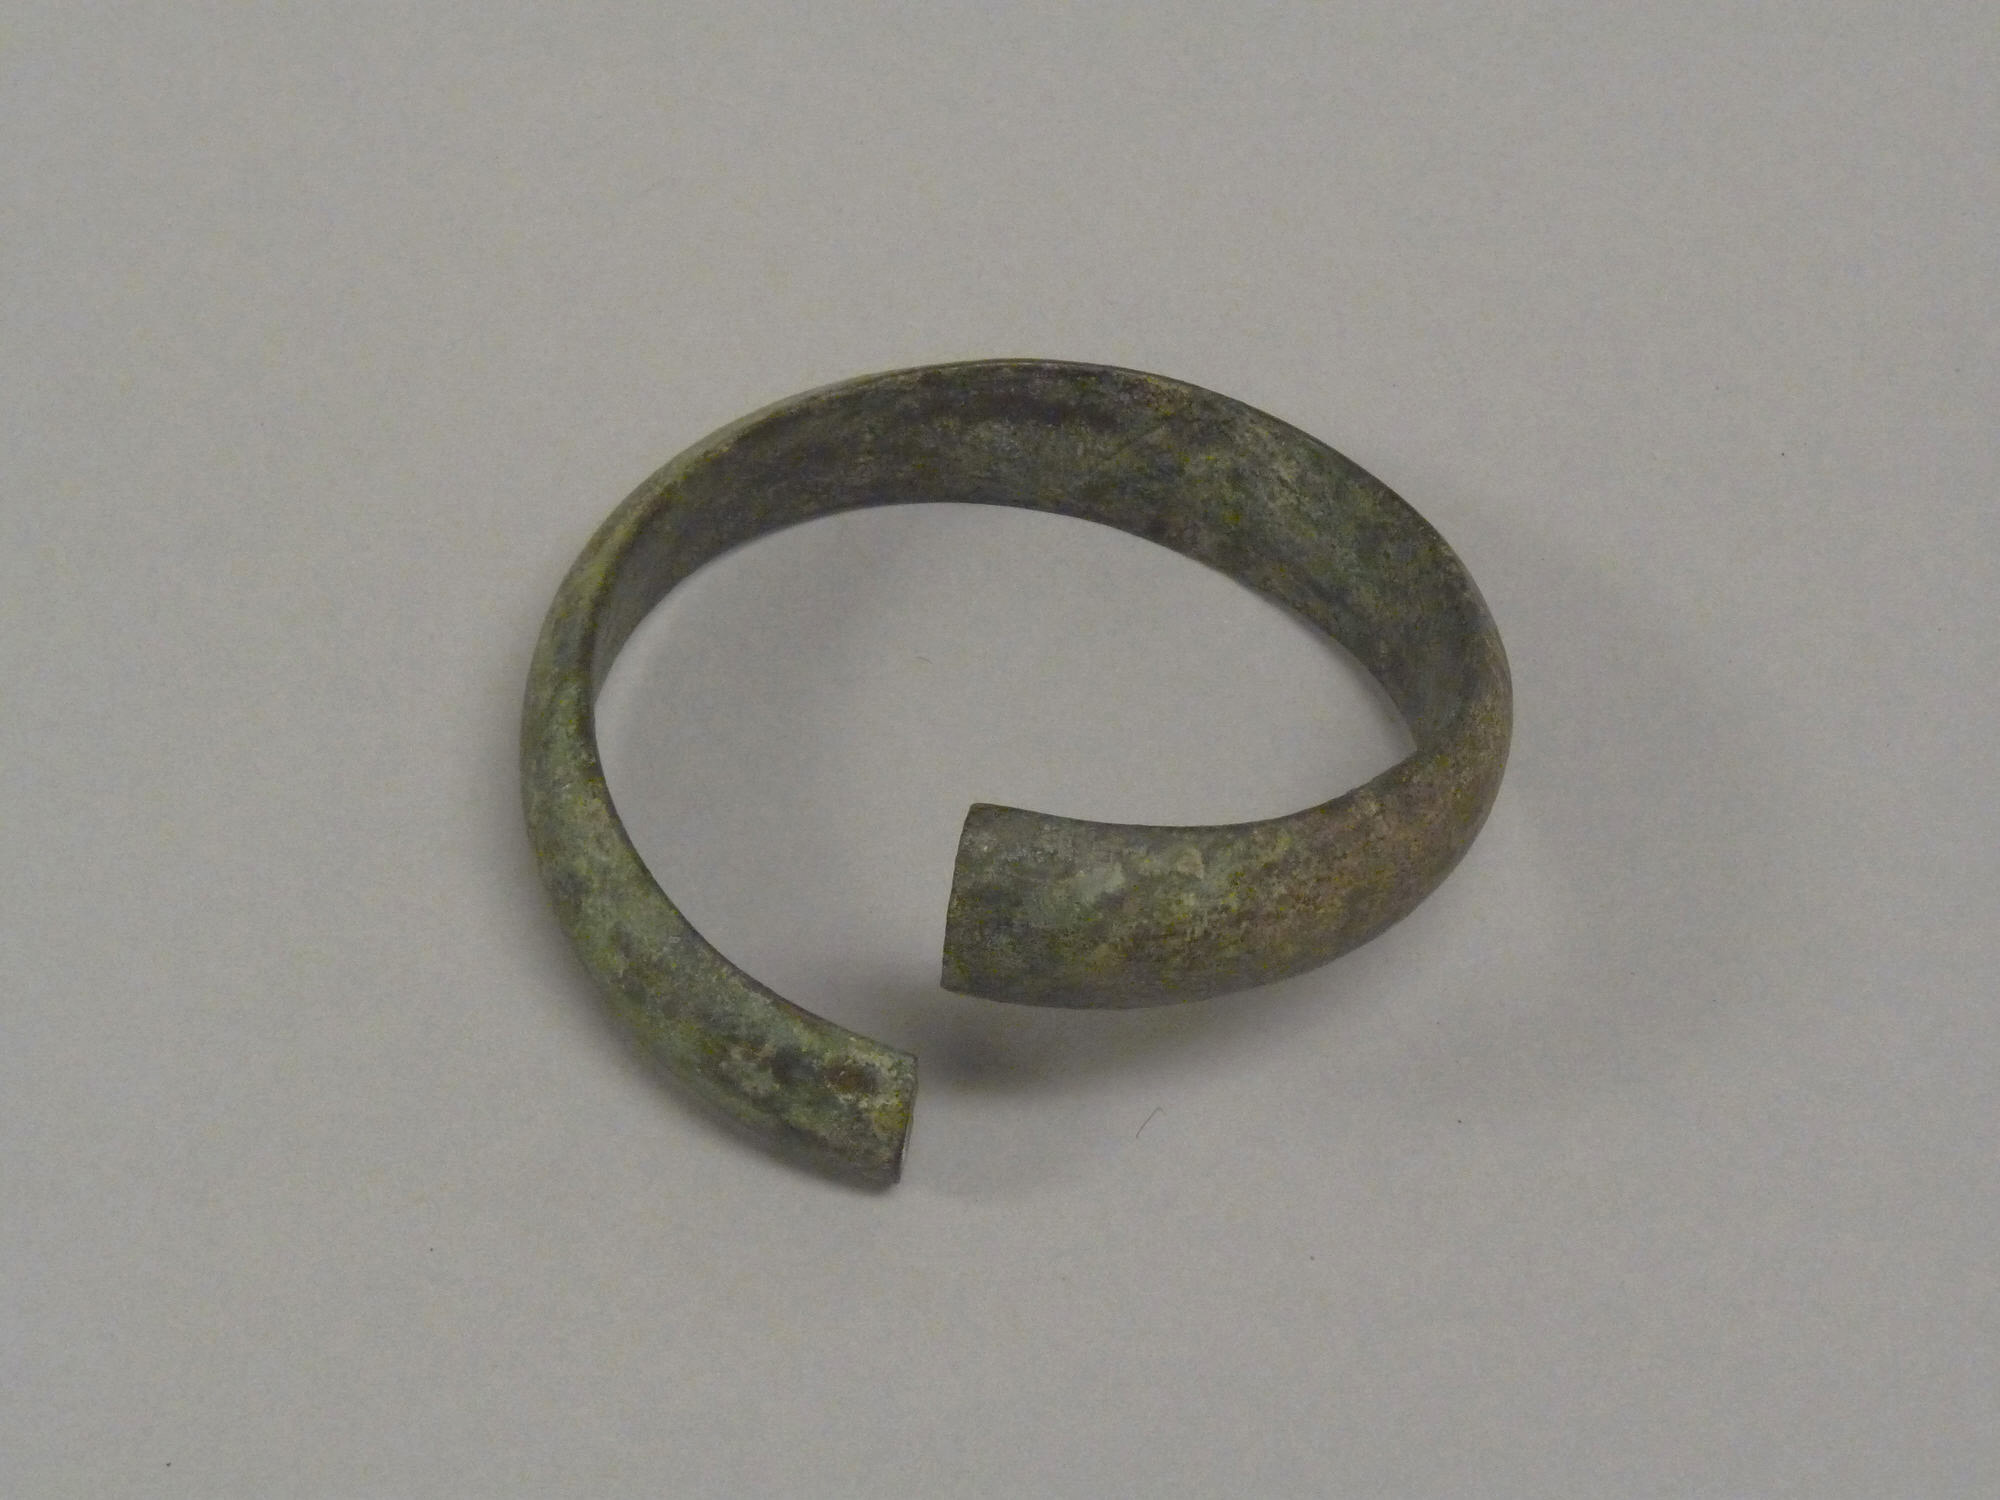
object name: anklet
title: One from a Pair of Undecorated Torqued Anklets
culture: thai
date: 1000 BCE-400 CE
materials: bronze